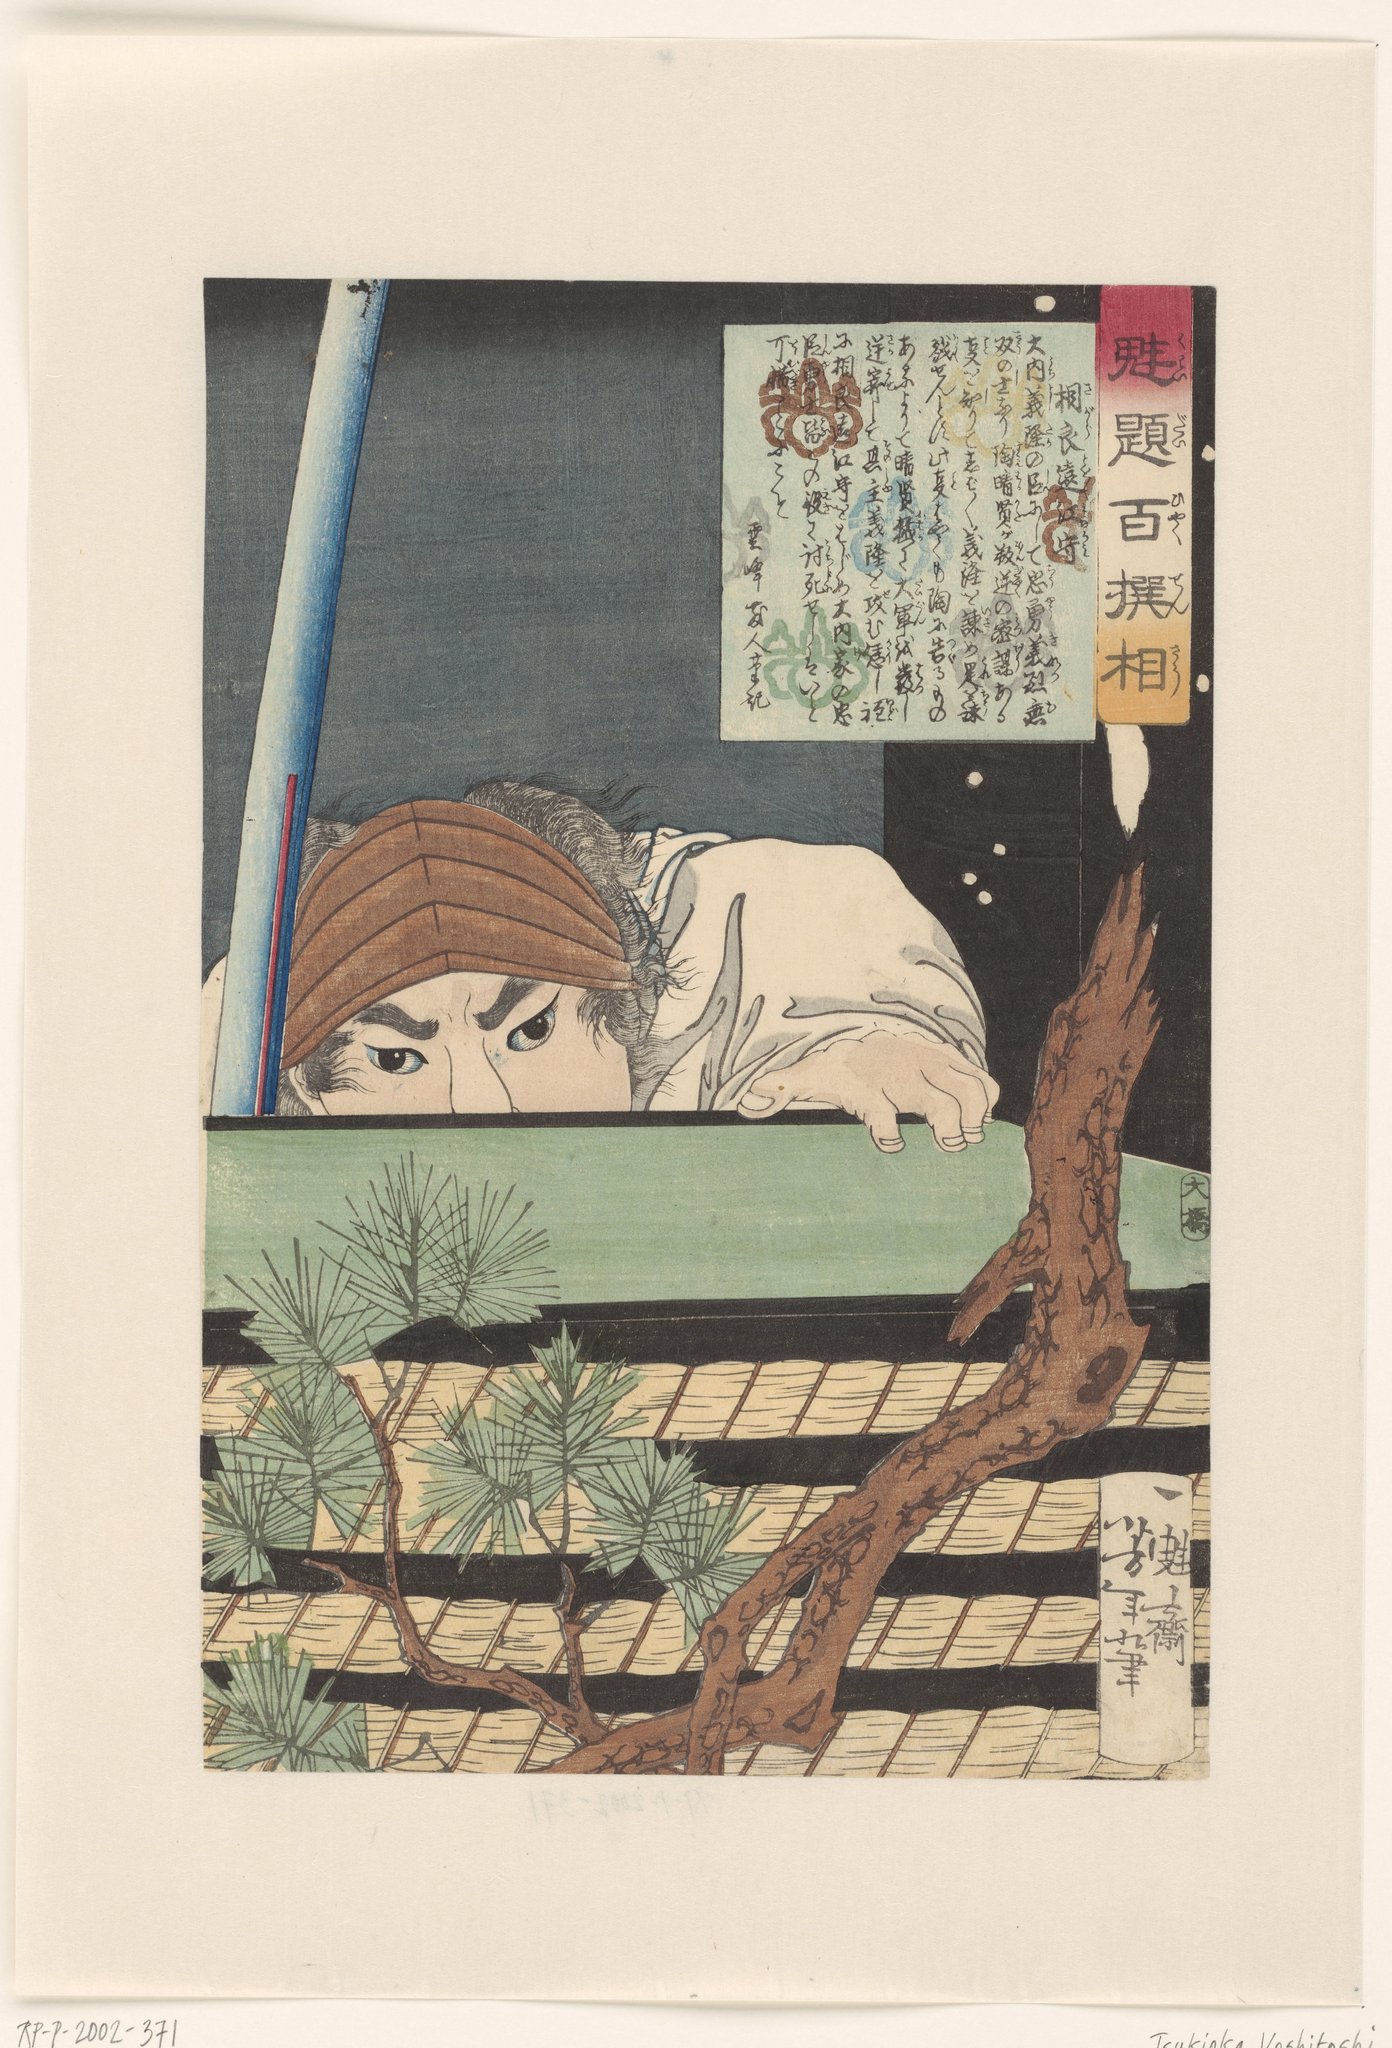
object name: print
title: Sagara Totomi no Kami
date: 1868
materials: paper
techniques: woodcut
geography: tokyo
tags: hacking and thrusting weapons: sword, hiding, hiding oneself, trees: pine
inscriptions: collector's mark: Lugt 2228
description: Sagara Totomi no Kami met geheven zwaard, zich veschuilend achter een stapel tatami matten. Een pijnboom op de voorgrond.